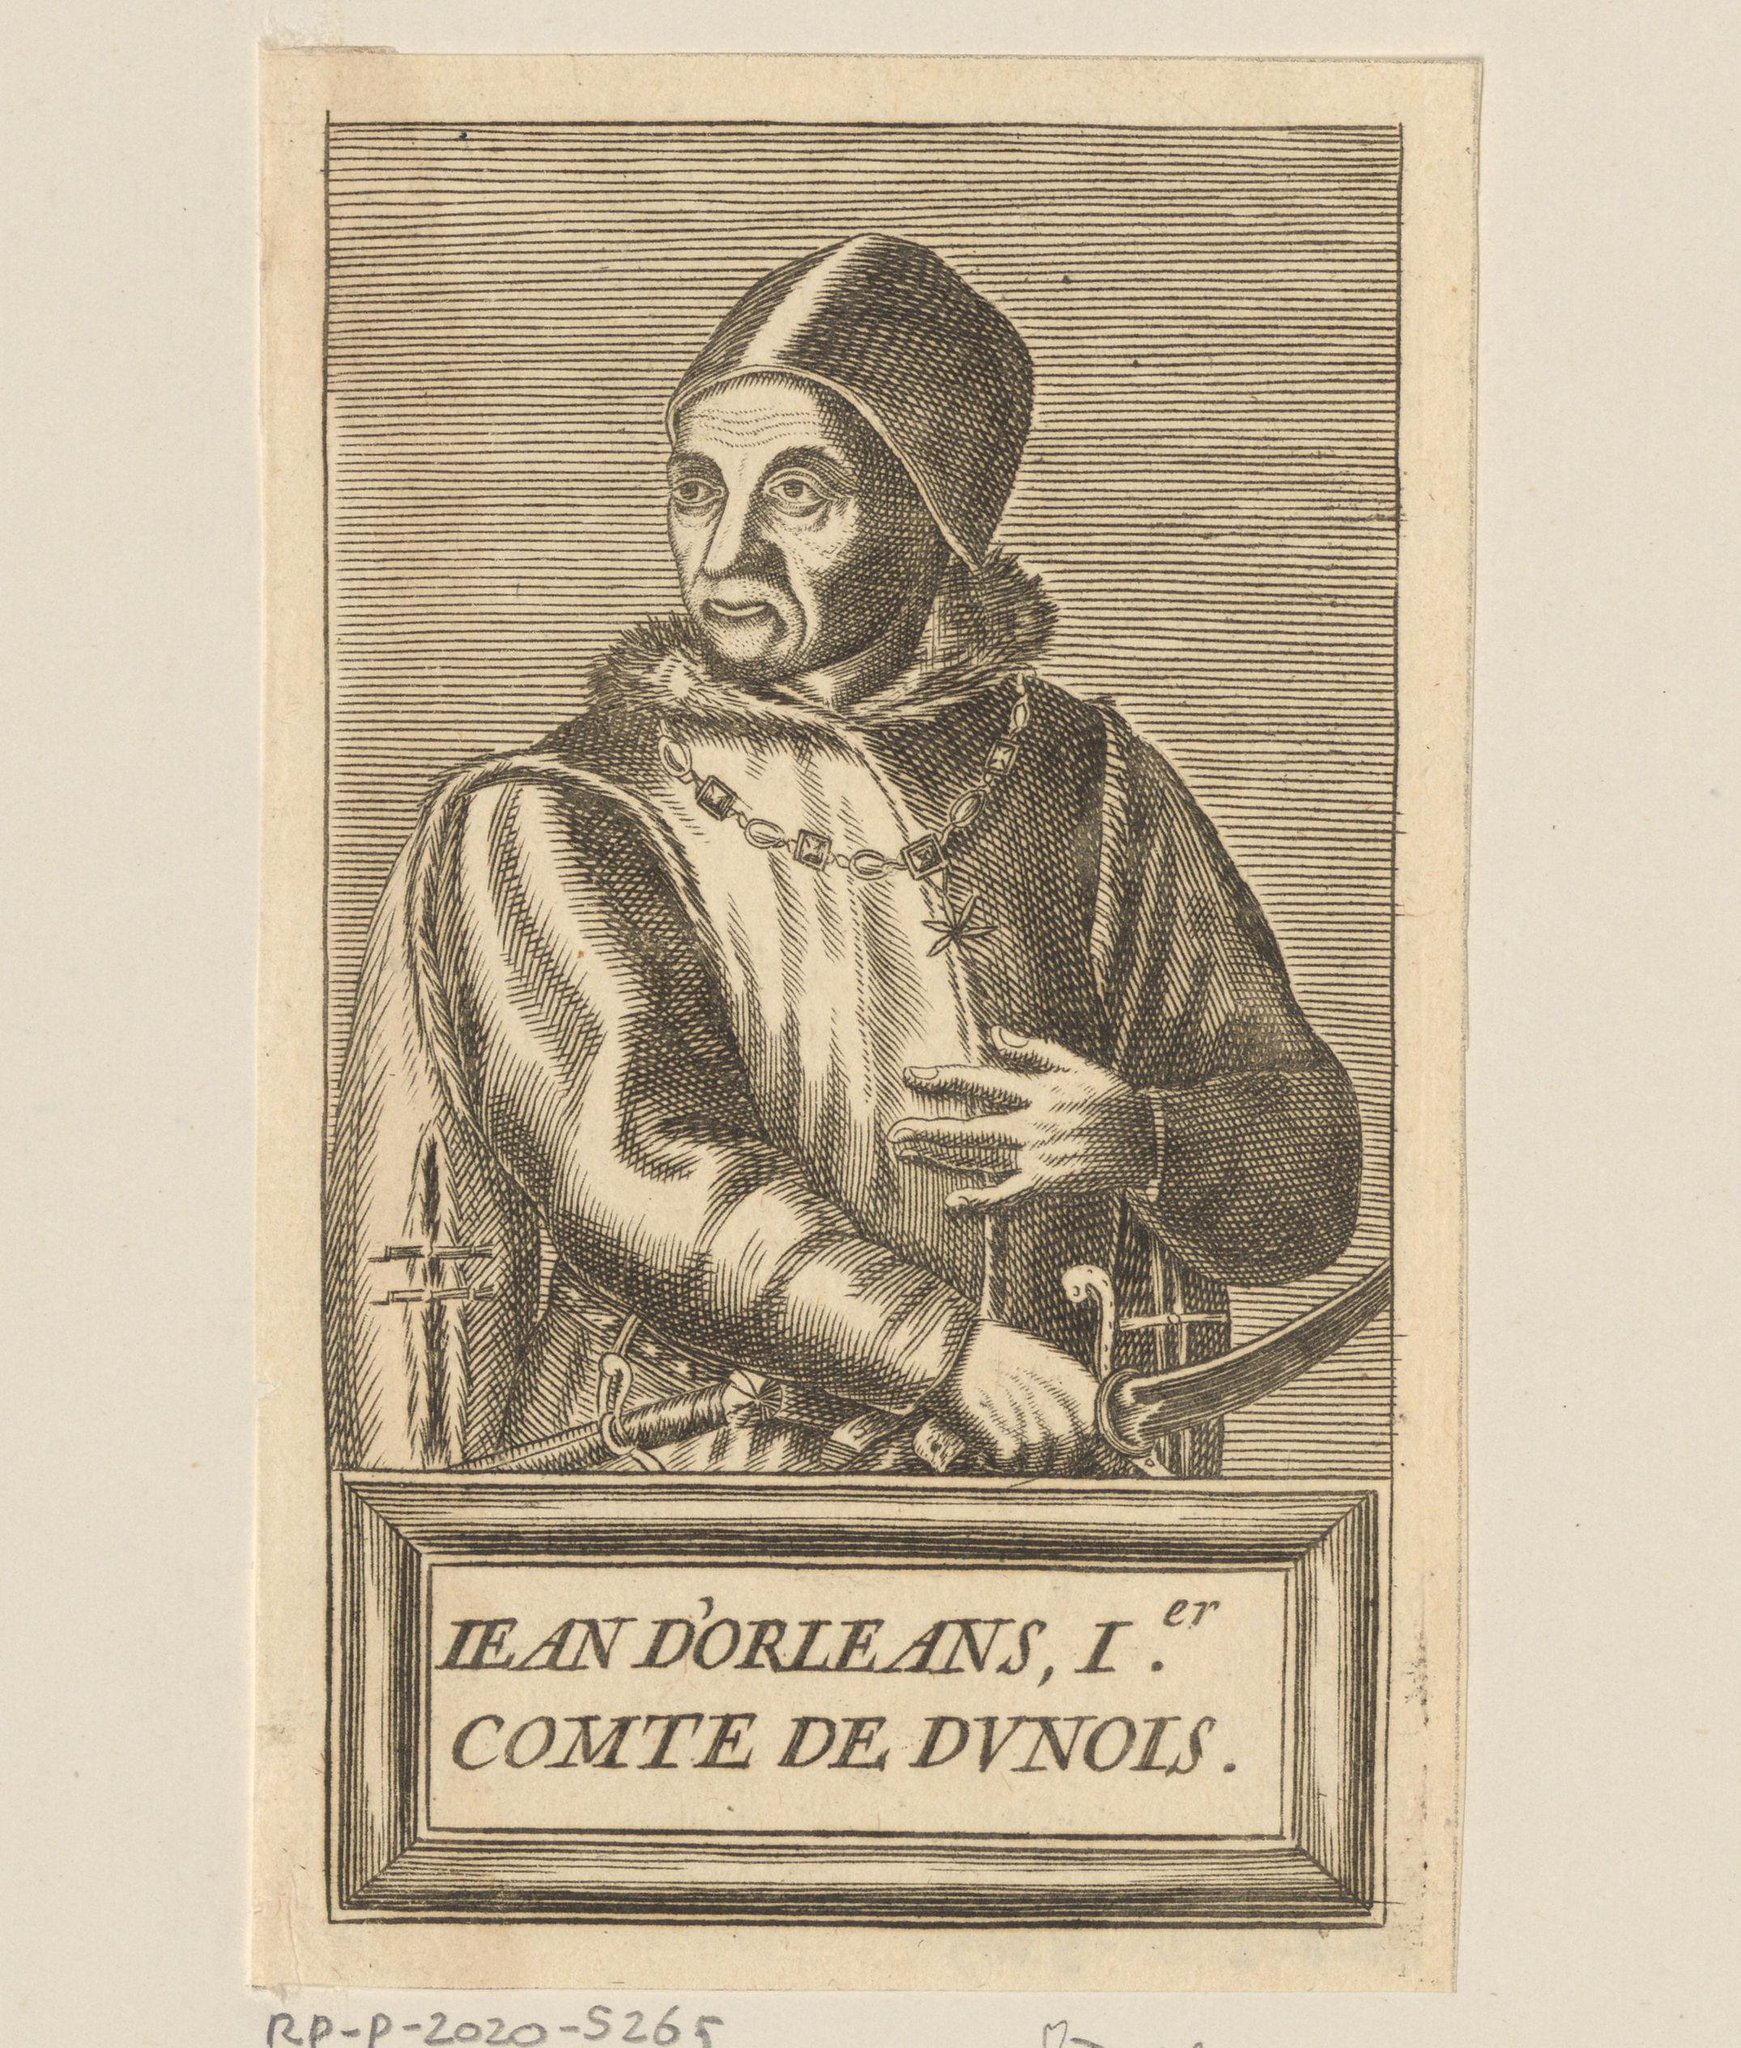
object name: print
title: Portret van Jean d'Orléans, graaf van Dunois en Mortain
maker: Anonymous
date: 1670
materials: paper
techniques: engraving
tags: earl, military service, historical persons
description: Prent waarschijnlijk uit: Thevet, Andre. Histoire des plus illustres et scavans hommes de leurs siècles (...). Parijs: François Mauger, 1670, dl. 5.